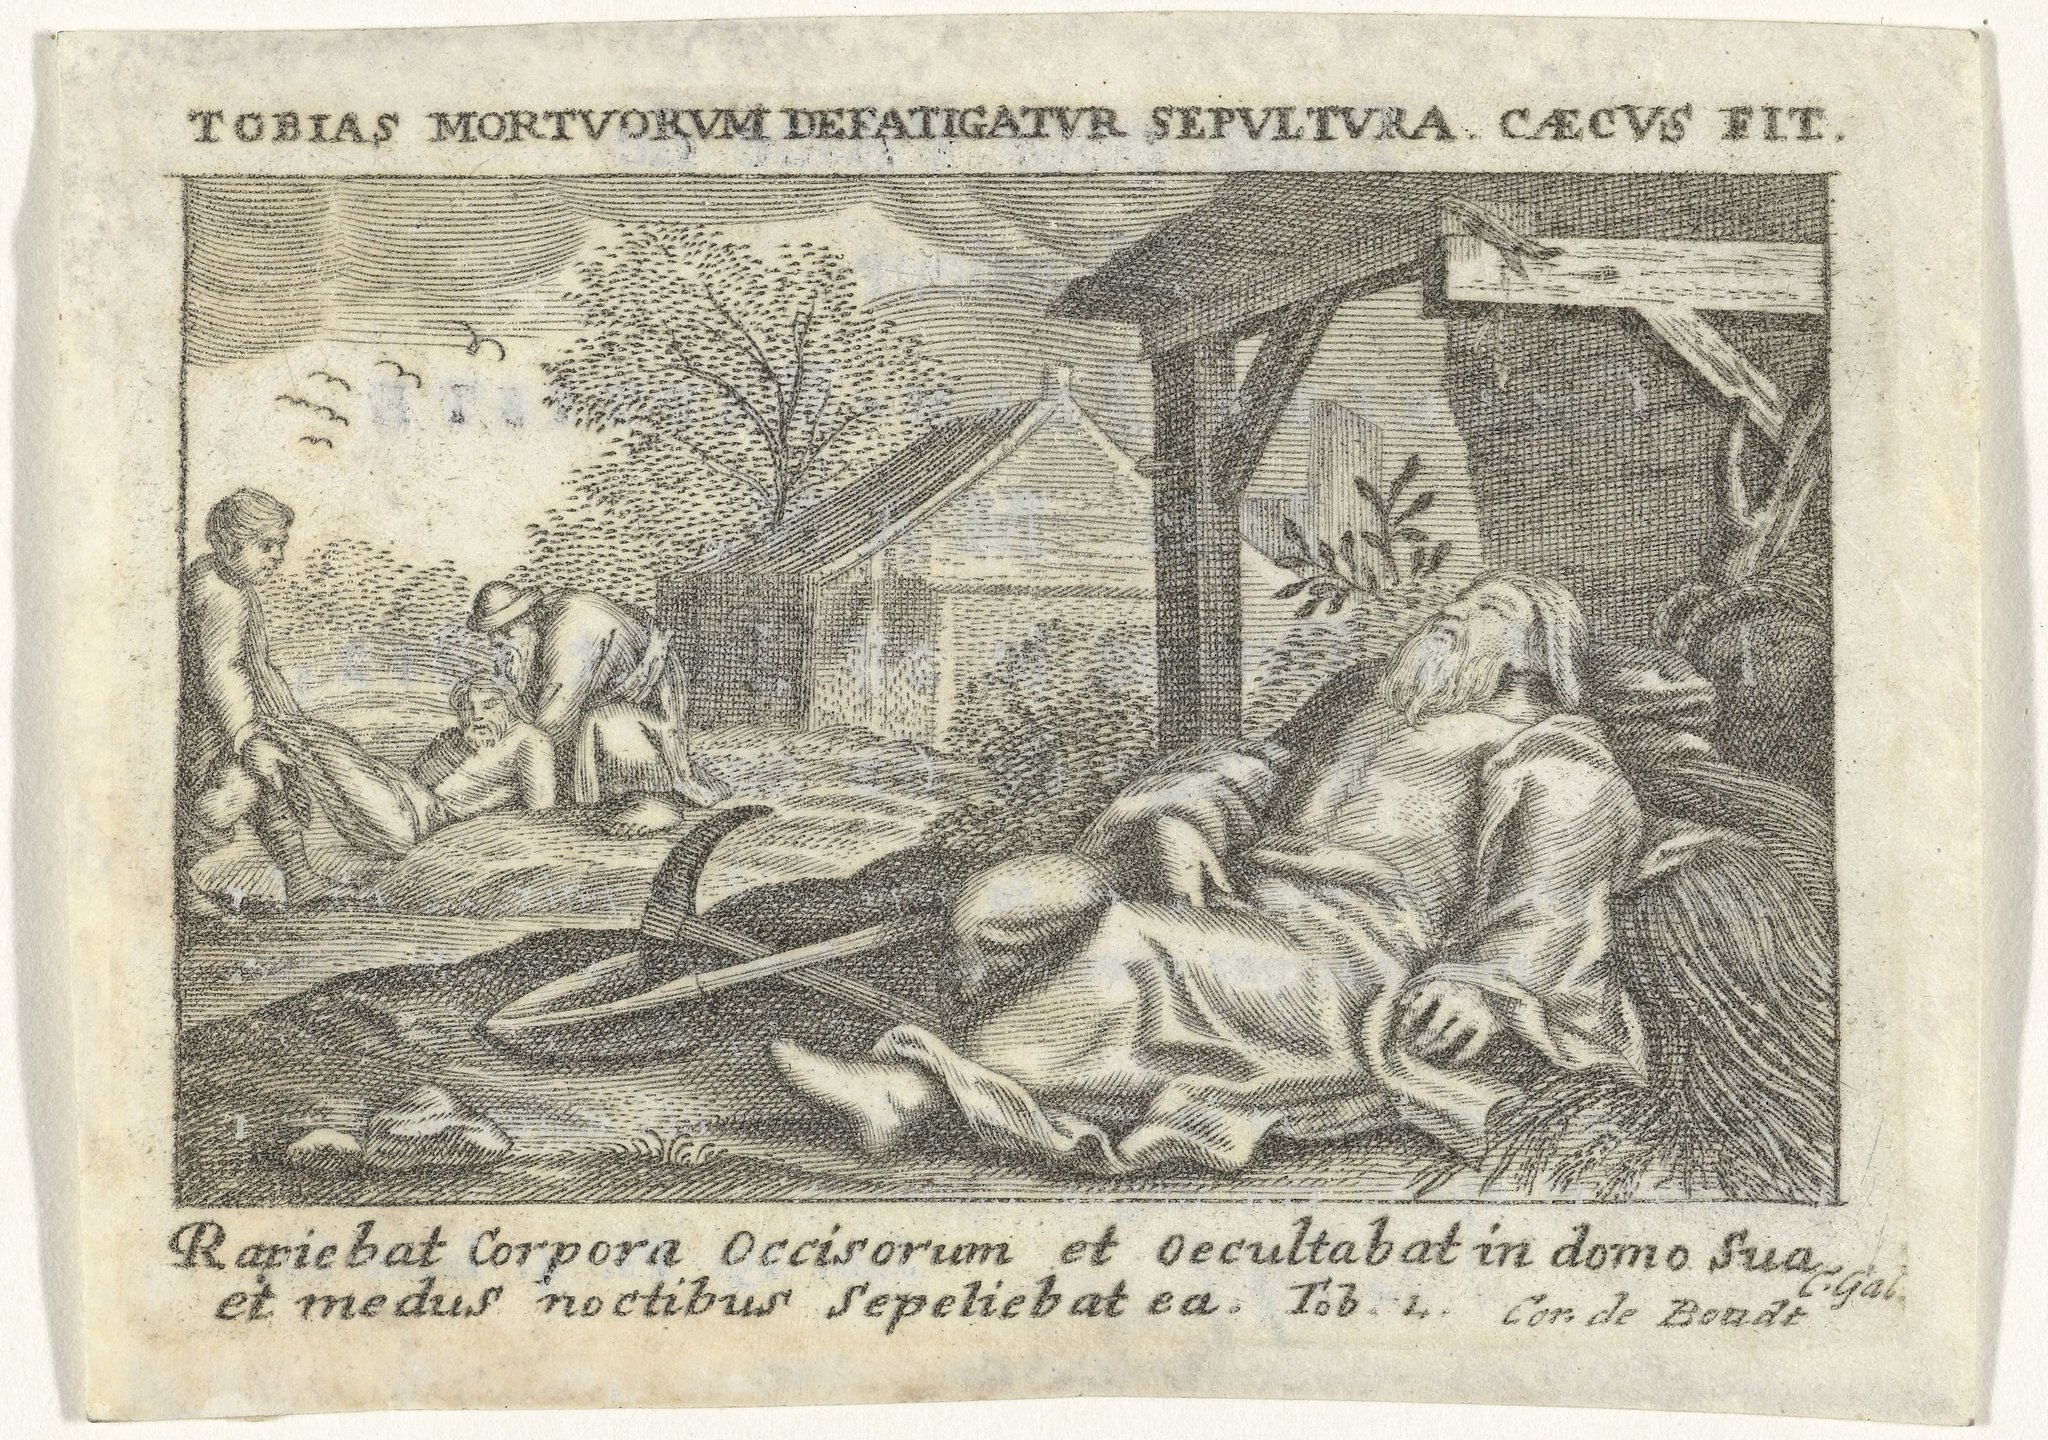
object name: prayer card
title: Tobias ligt te slapen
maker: cornelis de bout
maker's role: print maker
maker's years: 1660-1735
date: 1638-1735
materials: parchment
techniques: engraving, letterpress printing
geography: antwerp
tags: tobit lies sleeping against a wall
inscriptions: collector's mark: Lugt 2228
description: Tobias ligt in de open lucht te slapen voor een stal. Op de achtergrond is te zien hoe hij blind wordt doordat vogels uitwerpselen in zijn ogen werpen. Op het verso een bidprent voor Charles Jean-Baptiste de Man uit Deurne, gestorven in 1812.